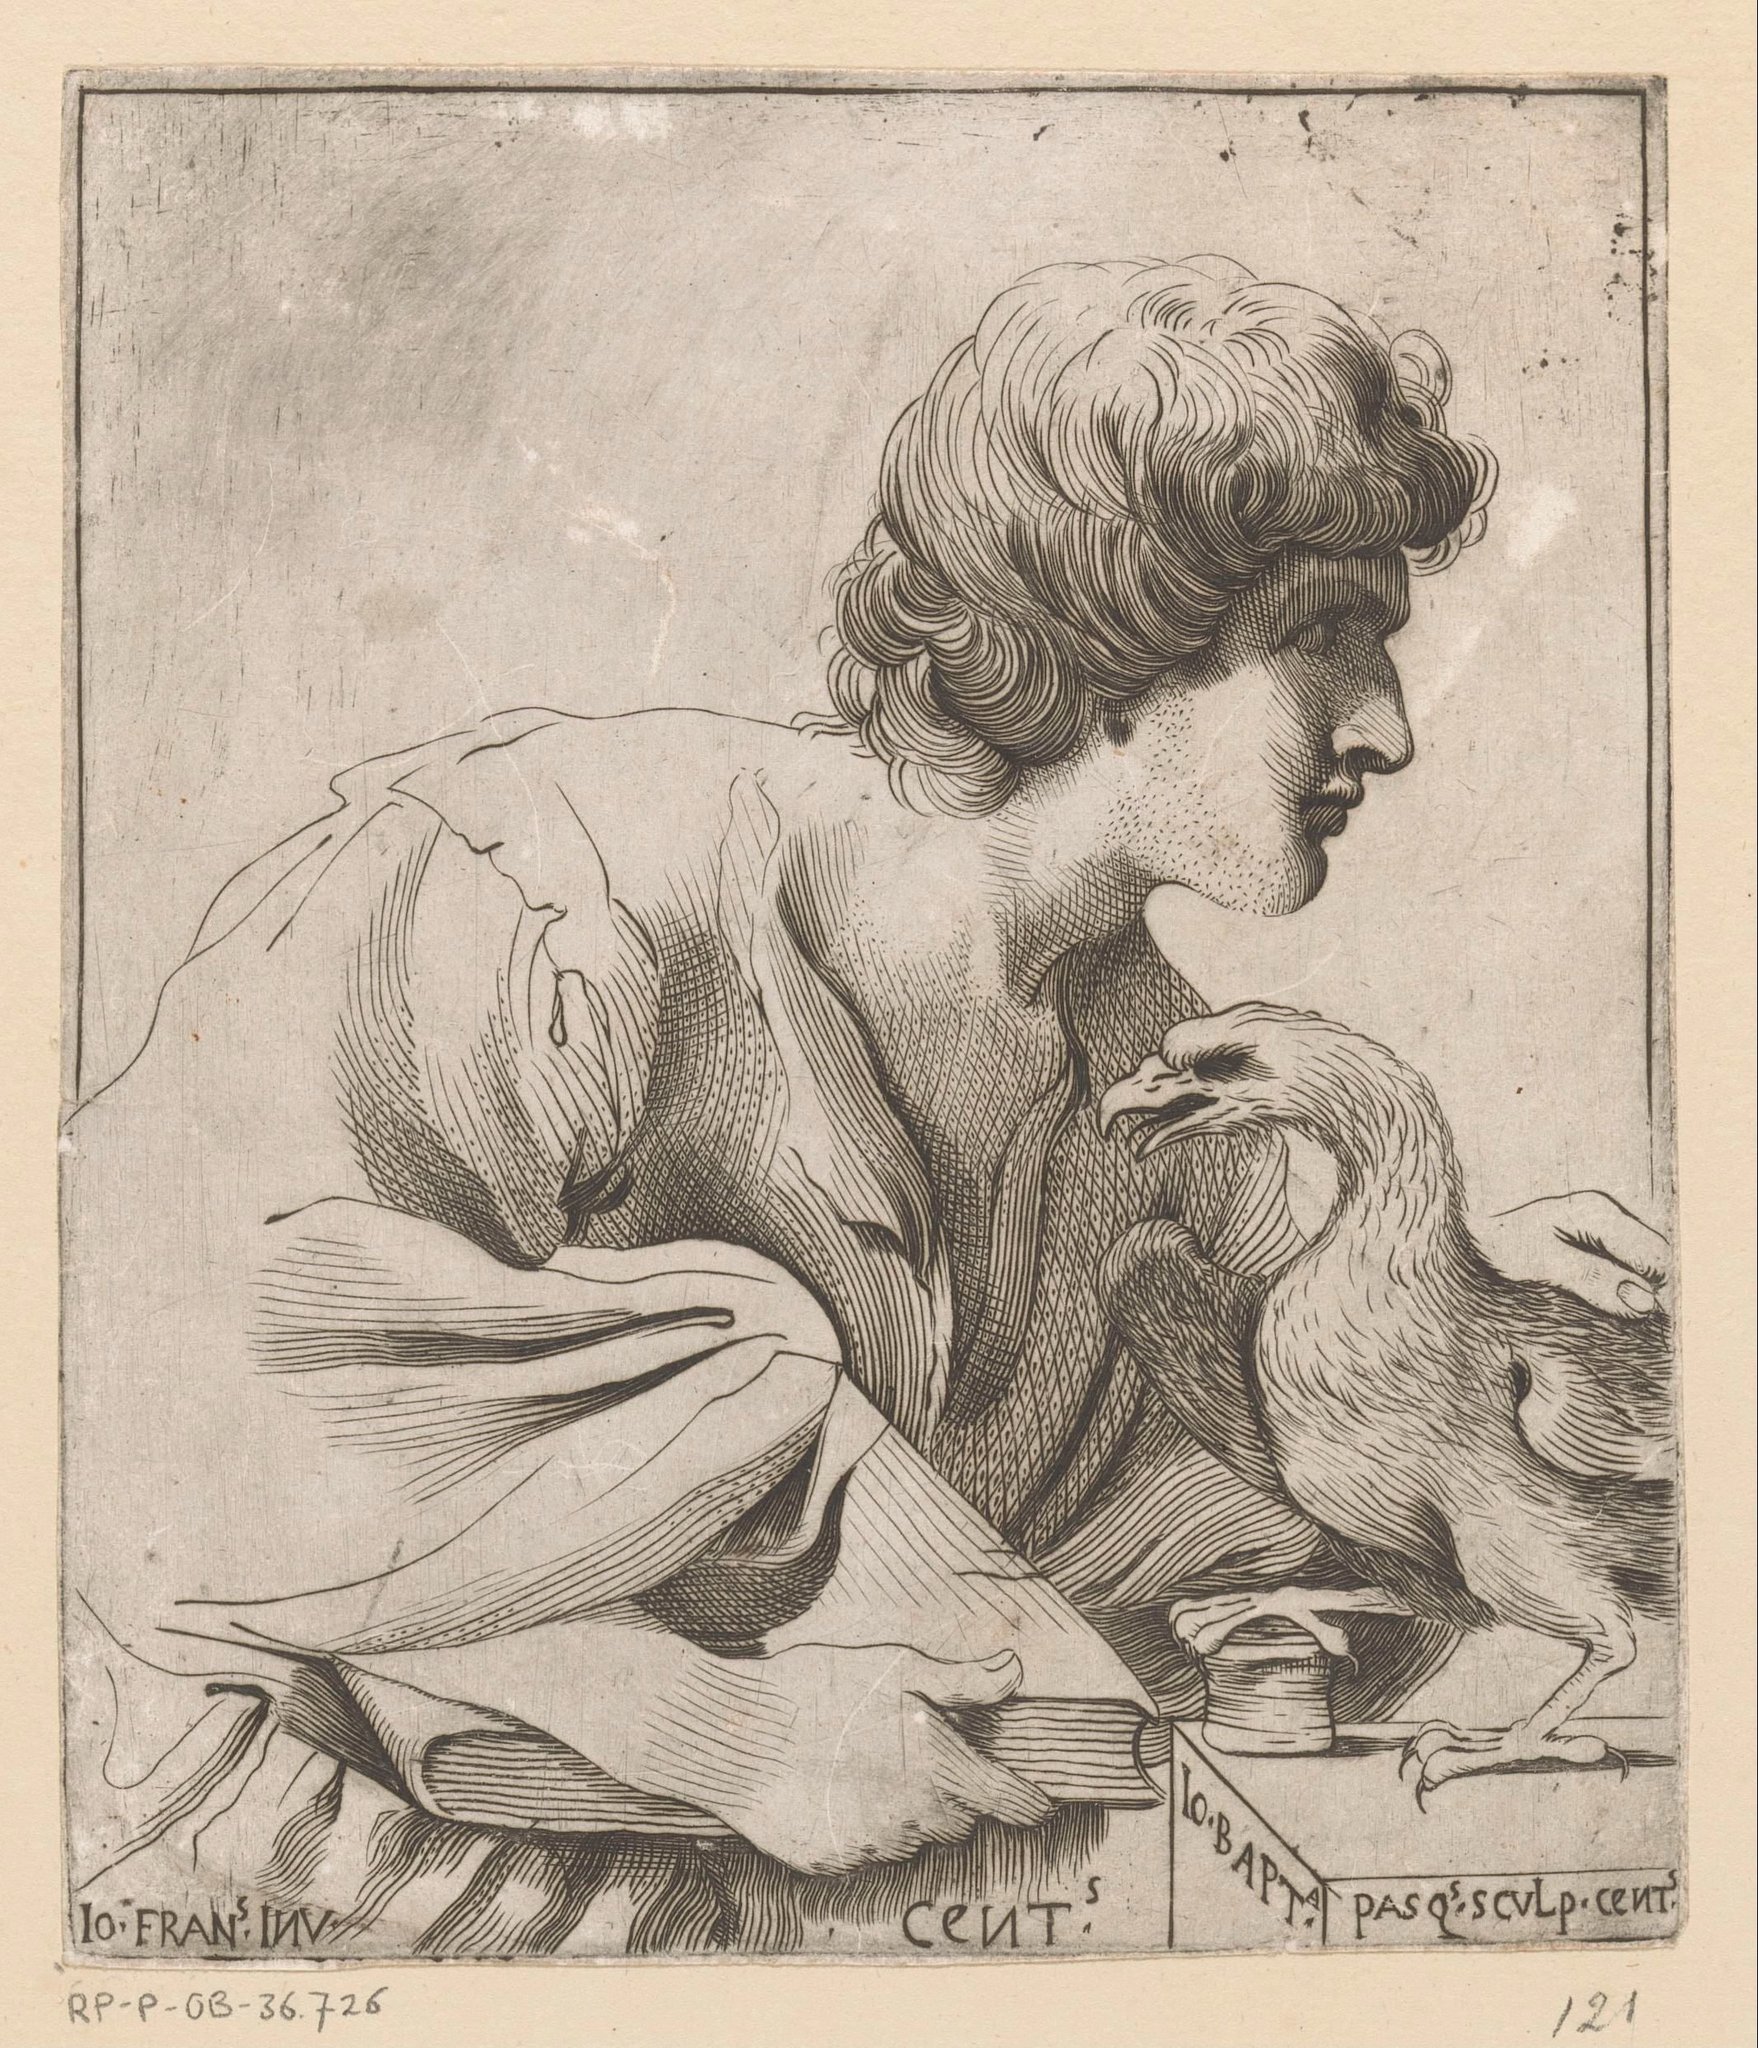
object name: print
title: Vier evangelisten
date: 1601-1634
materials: paper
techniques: drypoint, engraving, intaglio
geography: italy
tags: the apostle john the evangelist; possible attributes: book, cauldron, chalice with snake, eagle, palm, scroll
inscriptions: collector's mark: Lugt 240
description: Deze prent maakt onderdeel uit van een serie van vier prenten met de evangelisten.